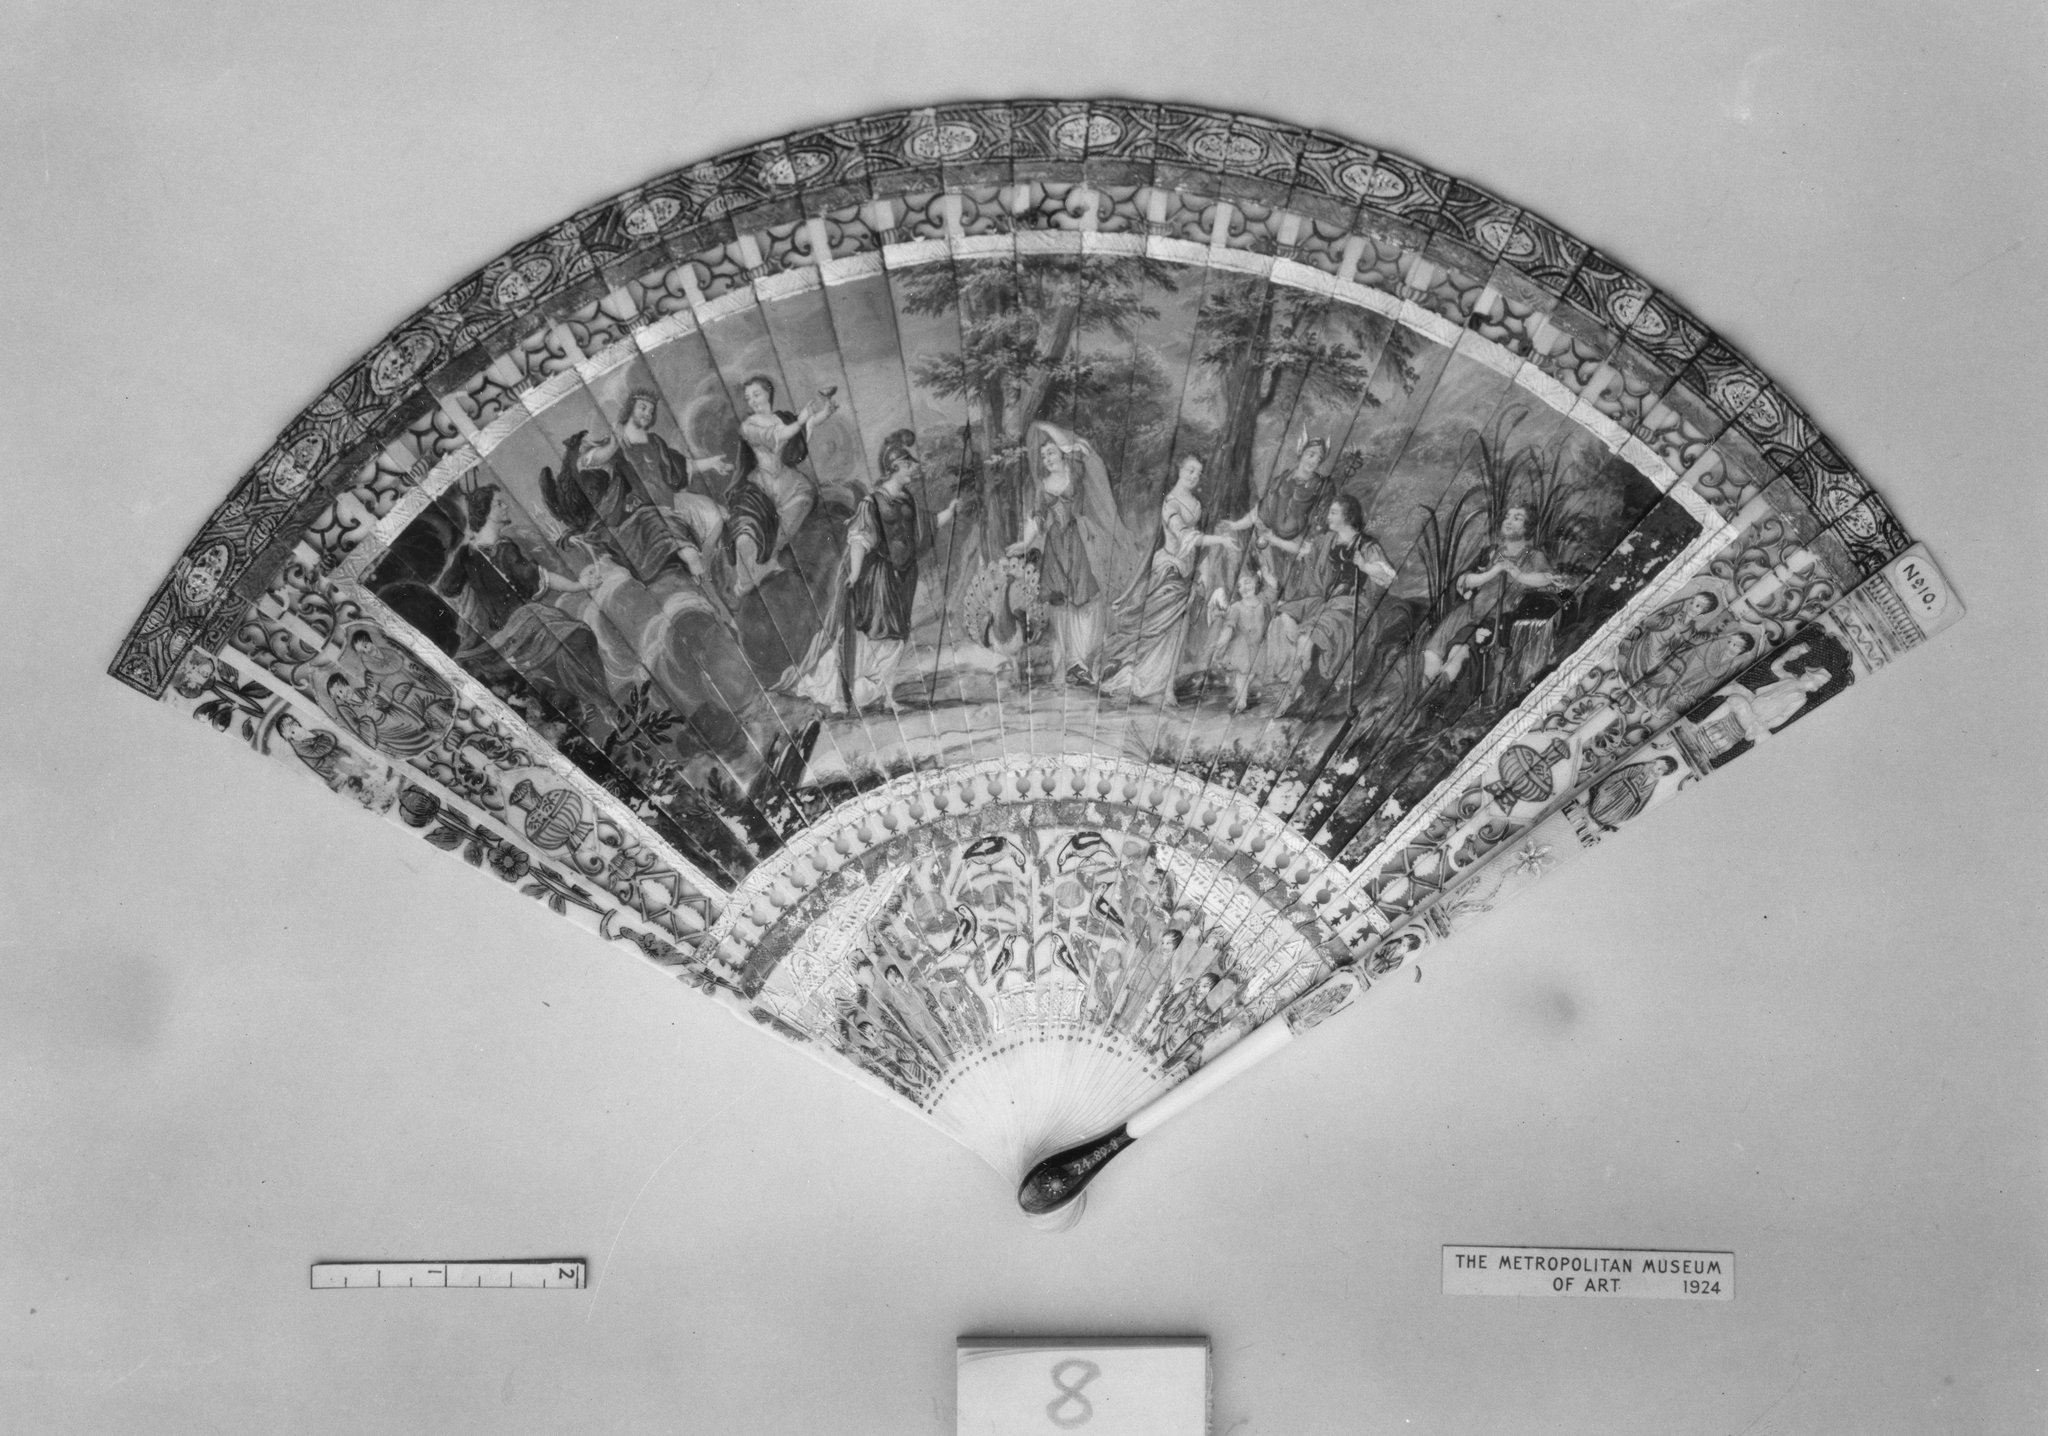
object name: fan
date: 1715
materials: ivory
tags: men,women